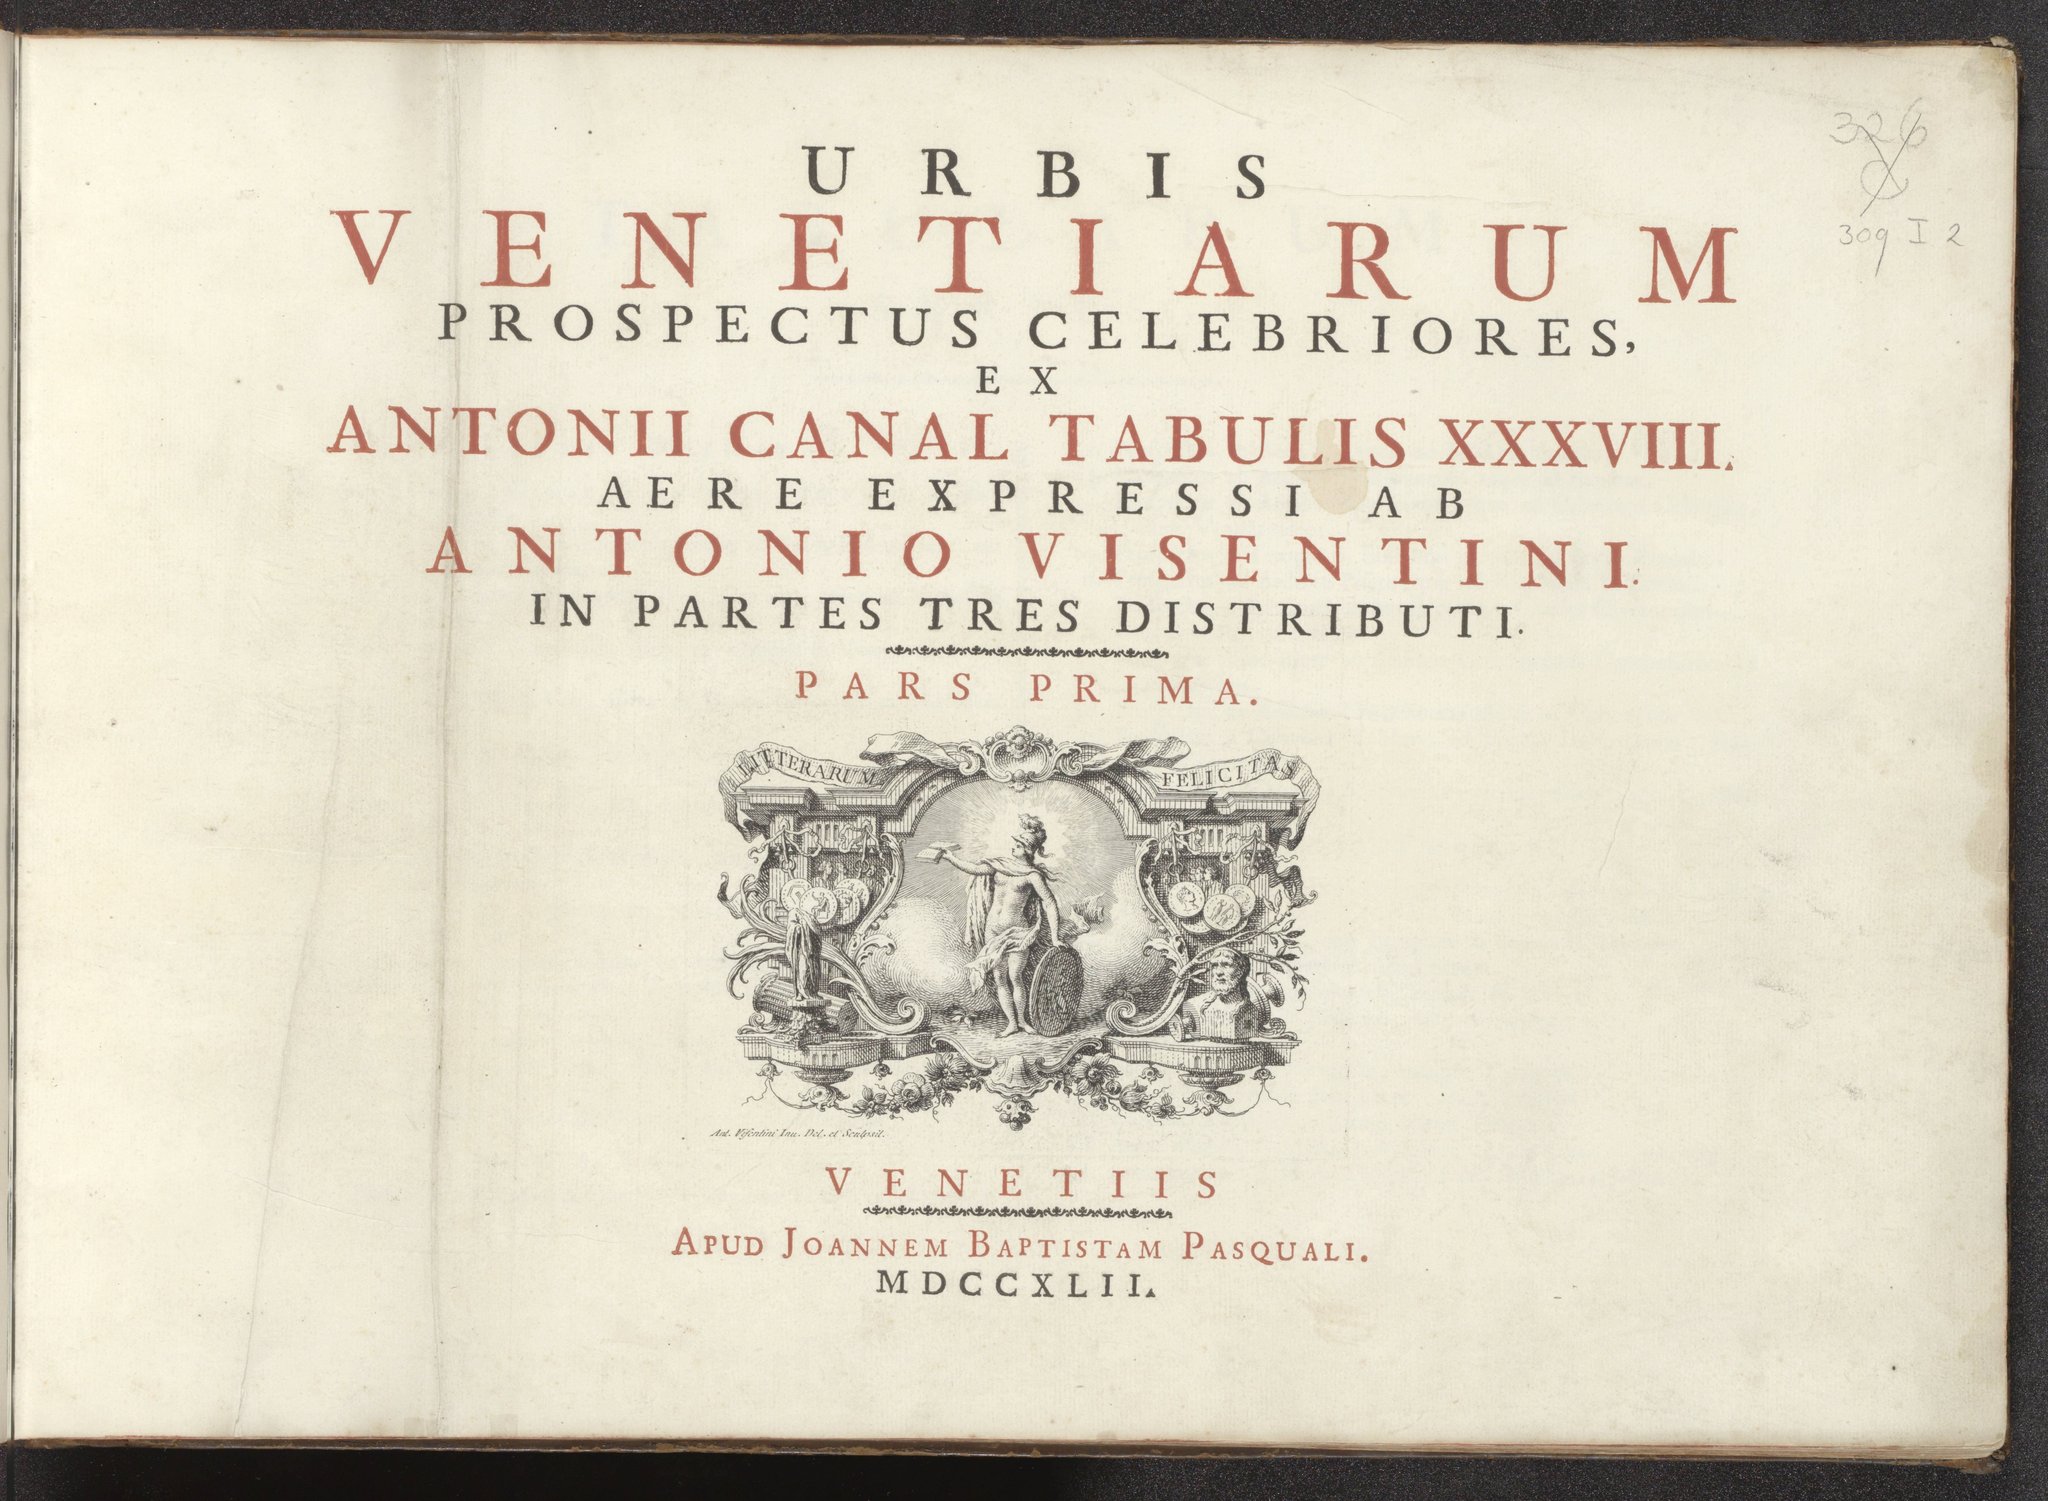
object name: titelprent, frontispice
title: Titelprent met een naakte vrouwenfiguur met schild, helm en boek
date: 1742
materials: paper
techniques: etching, letterpress printing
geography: venice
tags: venice, painter, print maker, draughtsman, canaletto, abstract ideas and concepts (+ abstract concept represented by female figure), ornament ~ cartouche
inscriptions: stamp: ‘Bibliotheek Rijksmuseum Amsterdam’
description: Een cartouche met een naakte vrouwenfiguur met schild, helm en boek. Boven een banderol met de tekst: Literarum Felicitas. De prent maakt deel uit van een album.